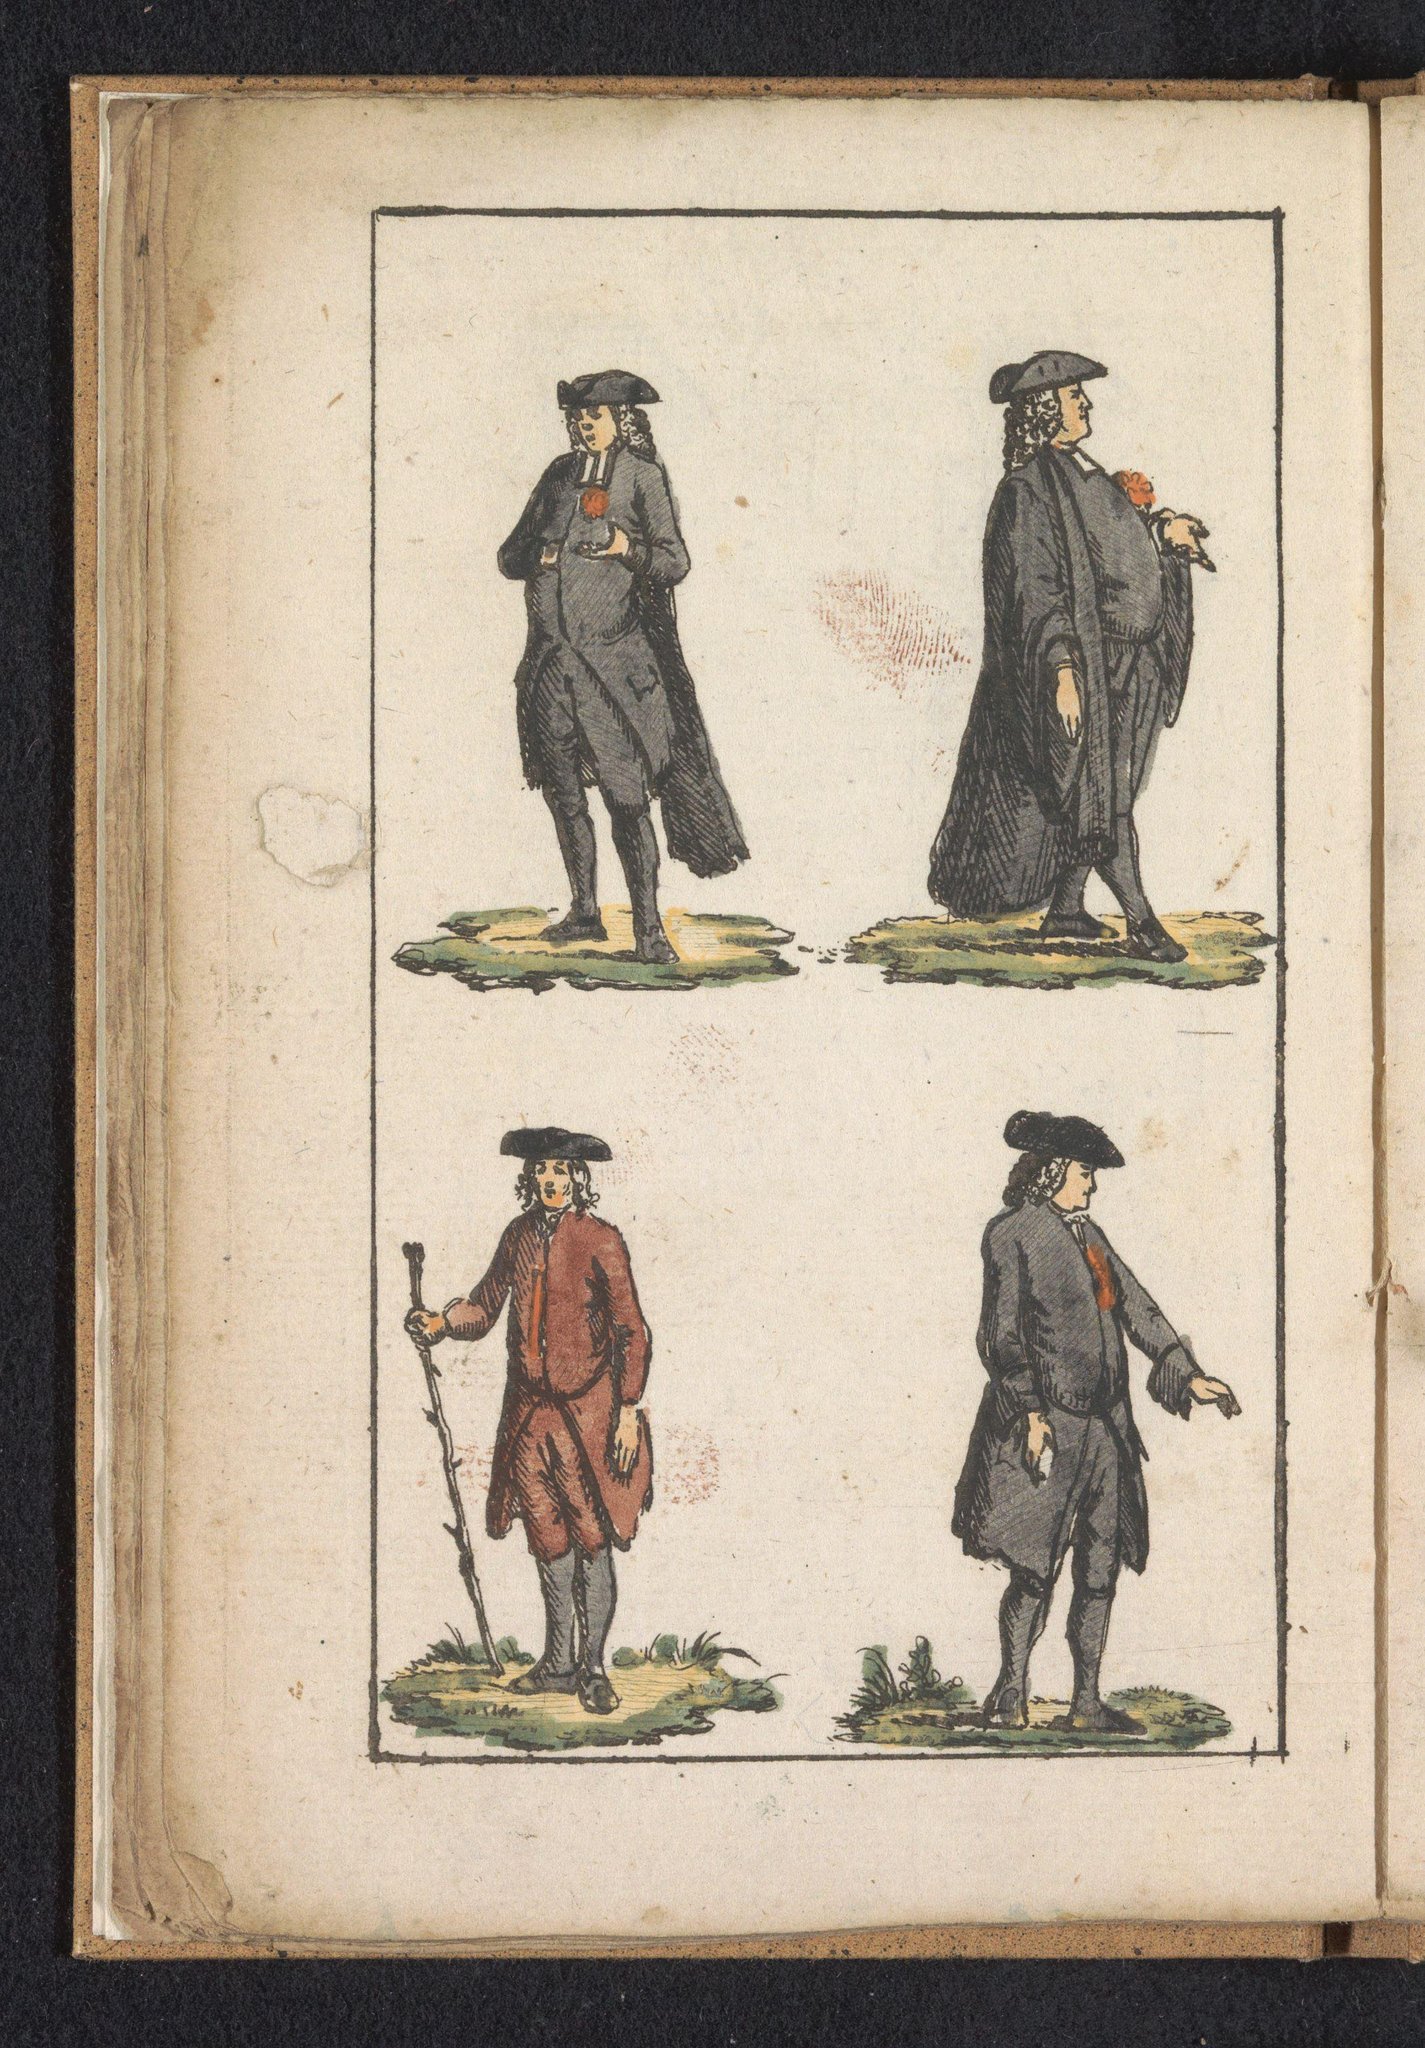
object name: print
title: Predikant en professor / Hernhutter en half eerwaarde, 1792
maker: Anonymous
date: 1792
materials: paper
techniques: etching, hand coloring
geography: northern netherlands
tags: clothes, costume (+ men's clothes), professor, patriots (1780-1795)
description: Kleding rond 1791-1792. Boven: kleding van een gereformeerde predikant en de toga van een professor in de rechtsgeleerdheid. Onder: een Hernhutse broeder en een 'Half Eerwaarde'. Illustratie in een boekje over mode en de dracht van oranje kokarde.